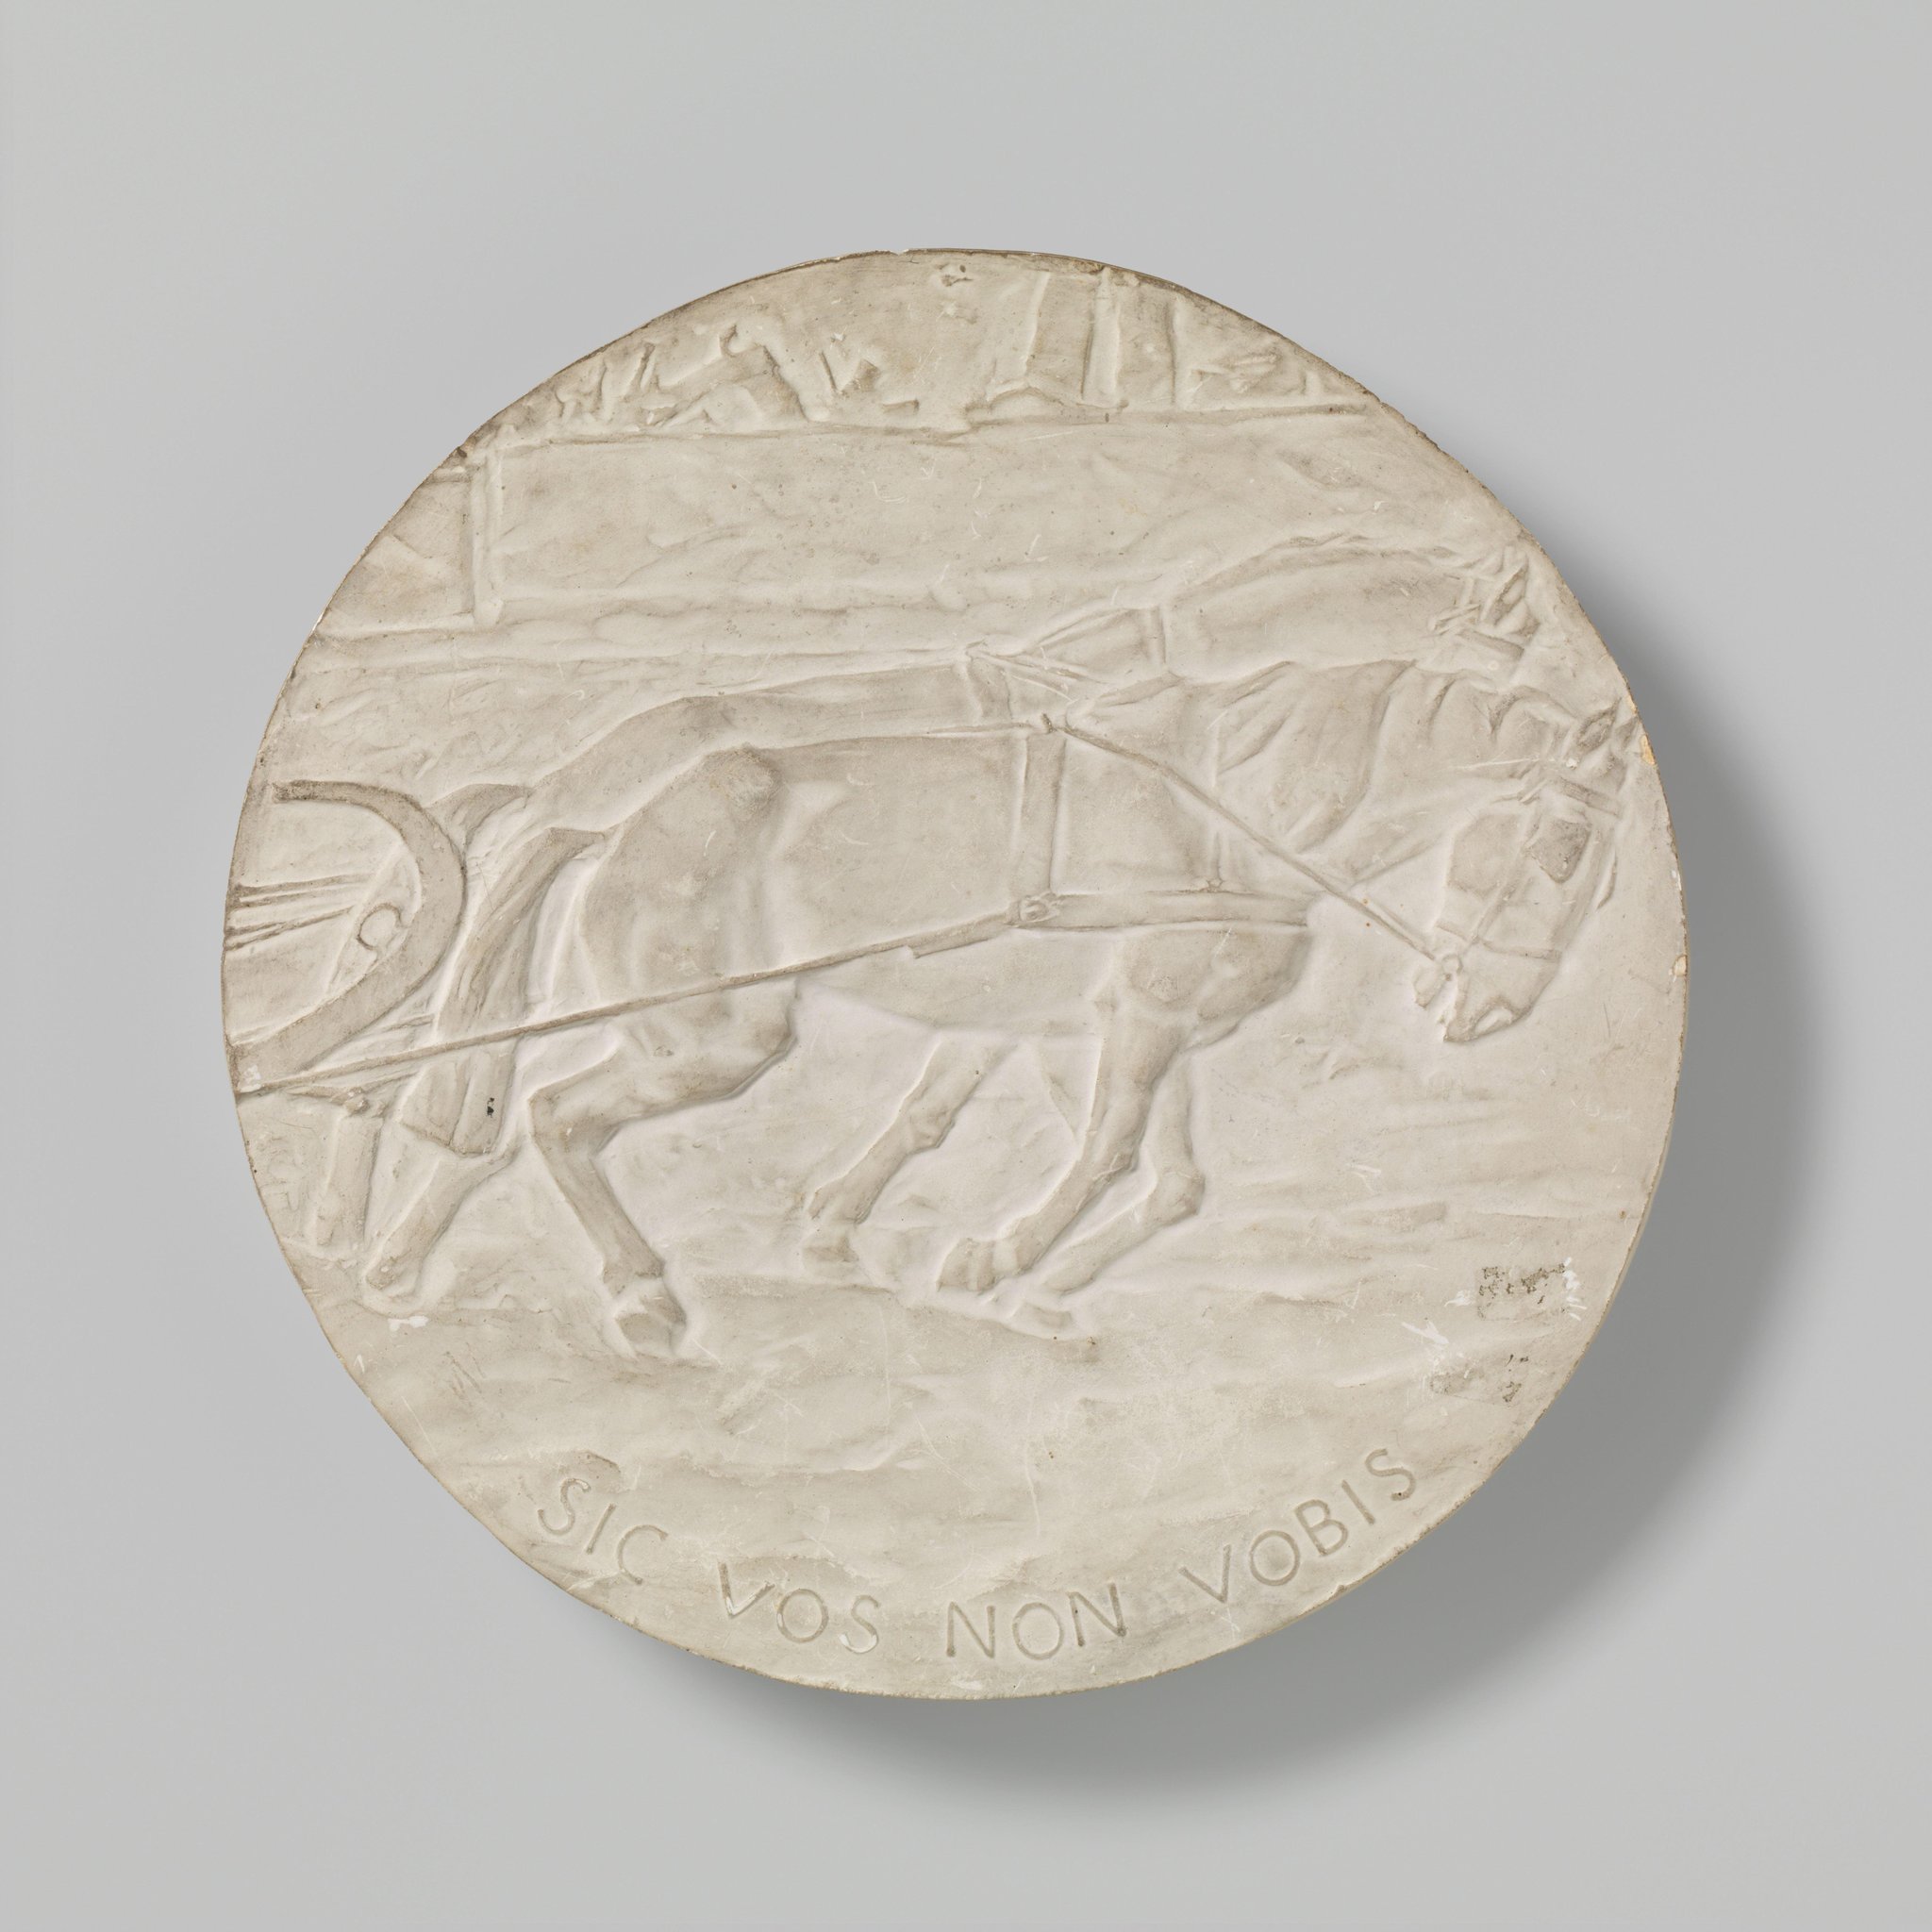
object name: plaque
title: Plaquette van gips, ontwerp voor een penning: trekpaarden met opschrift SIC VOS NON VOBIS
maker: lambertus zijl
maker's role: designer, draughtsman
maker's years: 1866-1947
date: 1876-1947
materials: gypsum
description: Plaquette, rond, van gips, met in reliëf trekpaarden en het opschrift SIC VOS NON VOBIS. Ontwerp voor een penning van Lambertus Zijl.